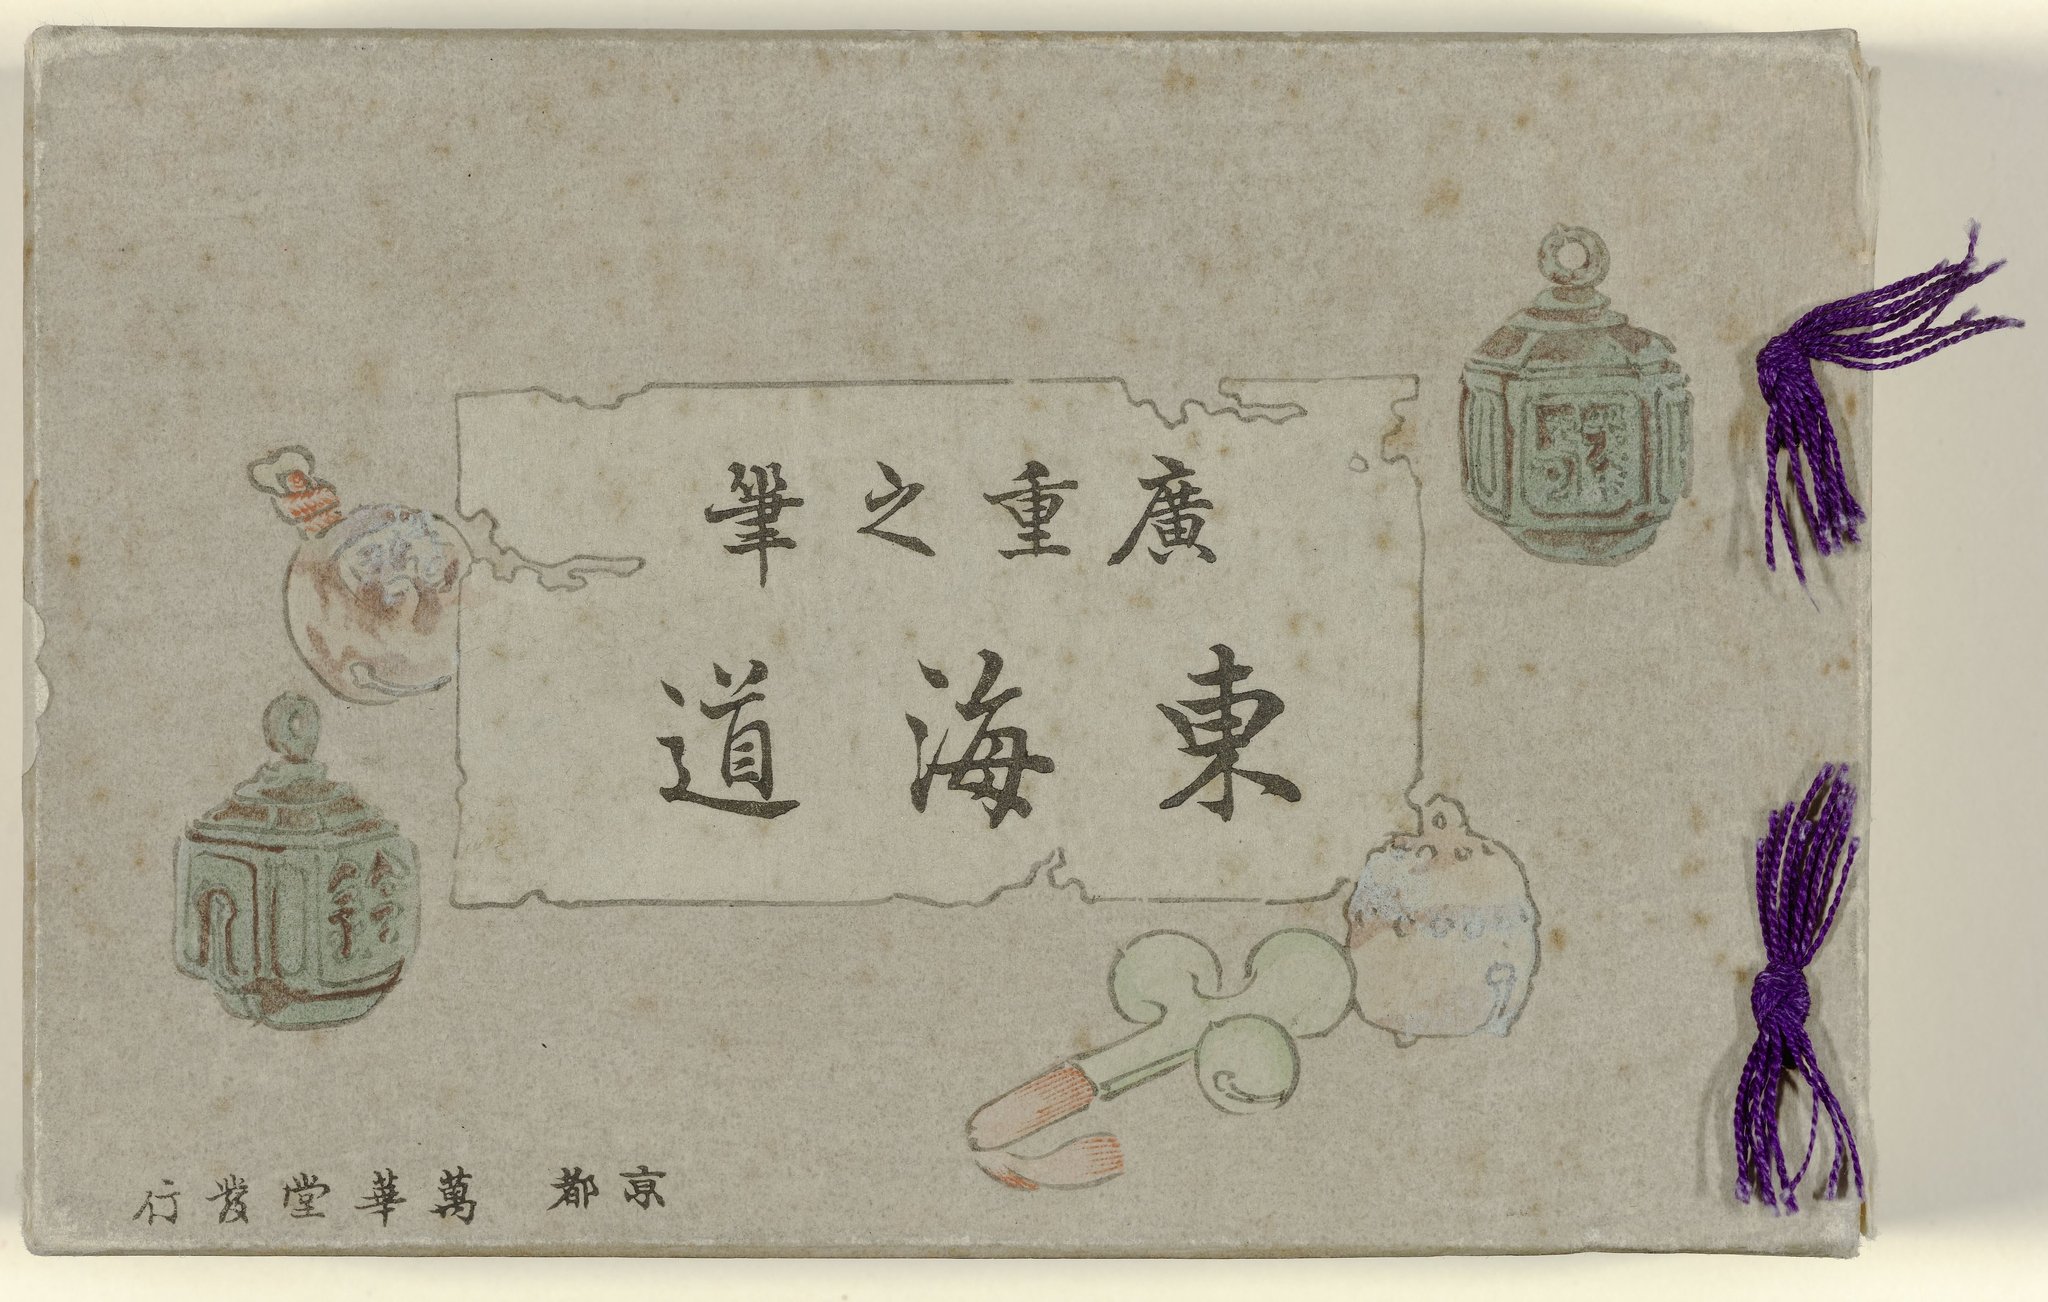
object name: ansichtkaart, prentbriefkaart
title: Vijfenvijftig Japanse prentbriefkaarten in doos van karton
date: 1906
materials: cardboard, paper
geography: japan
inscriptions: number: ‘1588 N. 24’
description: Doos voor vijftig prentbriefkaarten met ontwerpen naar de serie De 53 stations van de Tokaido (Tokaido gojusan no uchi) van Utagawa Hiroshige.